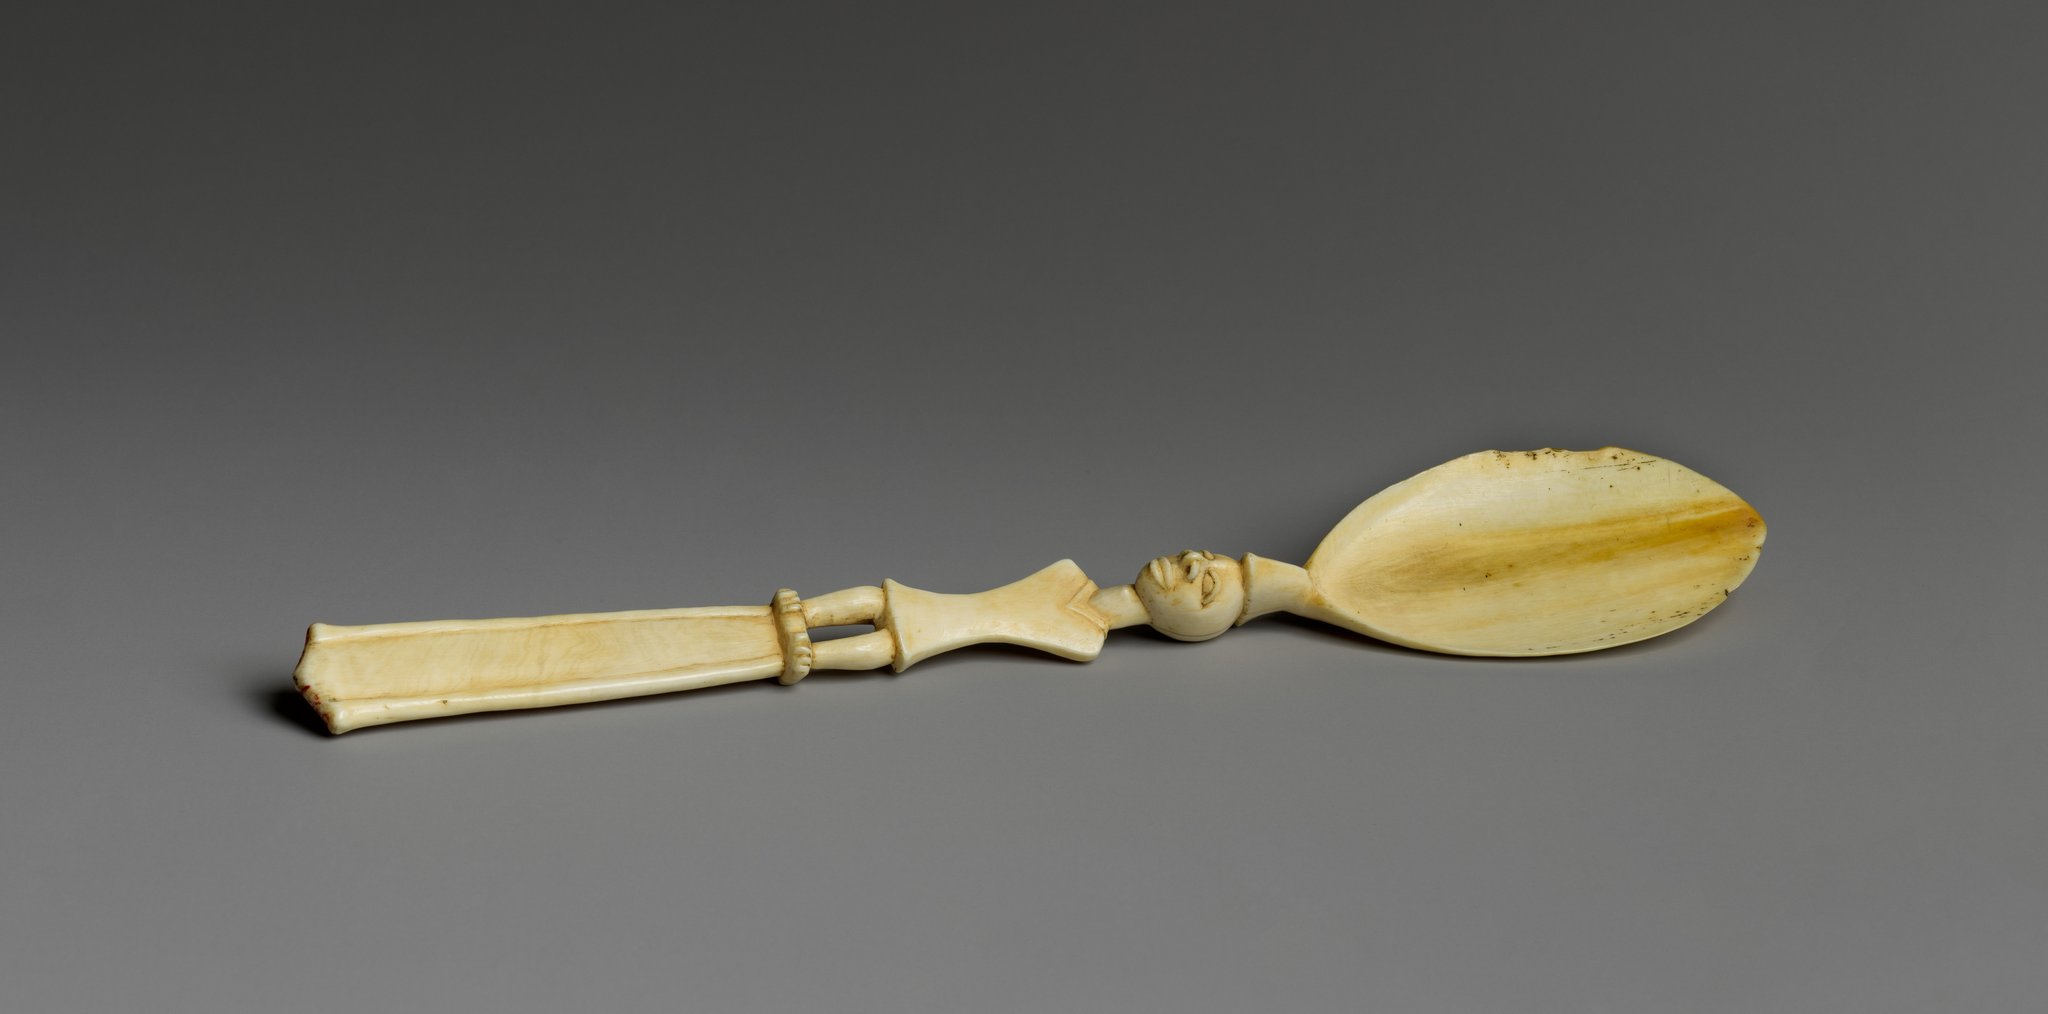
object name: spoon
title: Spoon with figure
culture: bullom or temne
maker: temne or bullom artist(s)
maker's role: artist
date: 1490-1530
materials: ivory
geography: sierra leone